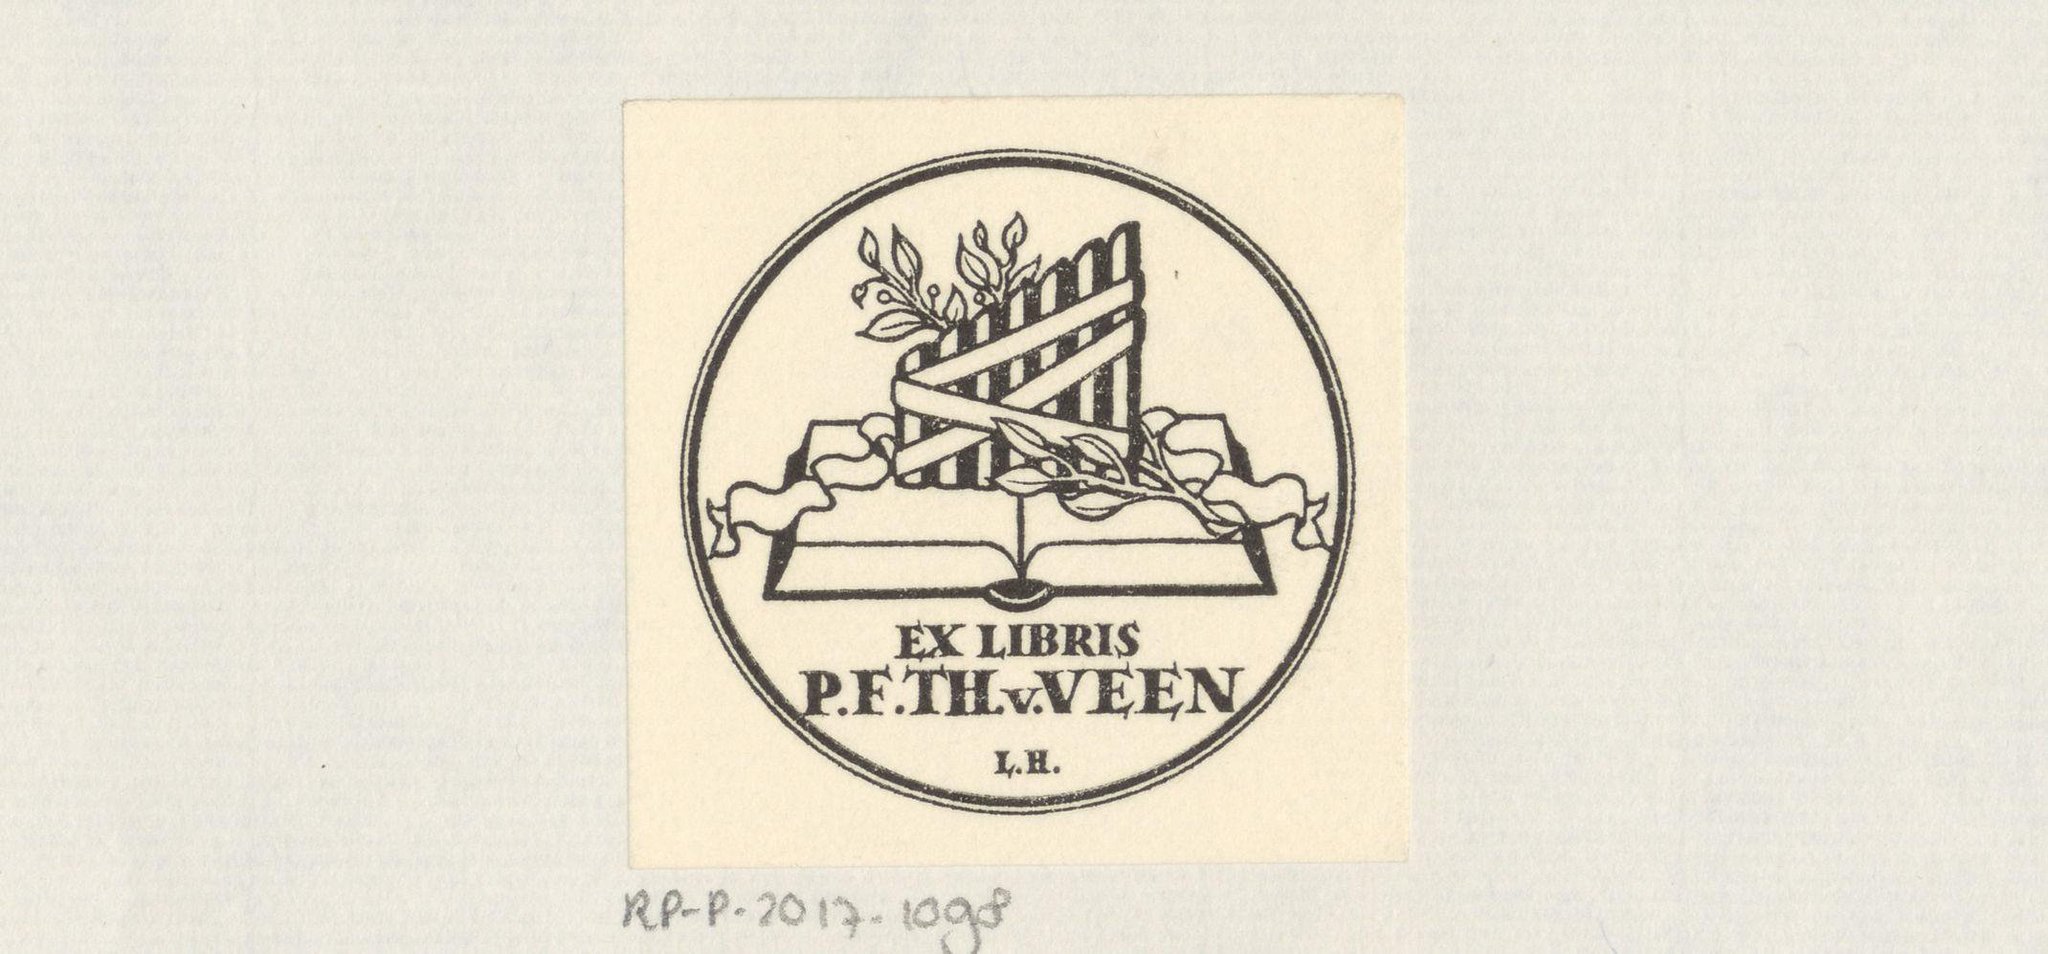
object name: bookplate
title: Ex libris van P.F.Th. van Veen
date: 1900-1999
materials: paper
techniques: printing block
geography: netherlands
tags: panpipes, book, foliage, tendrils, branches ~ ornament